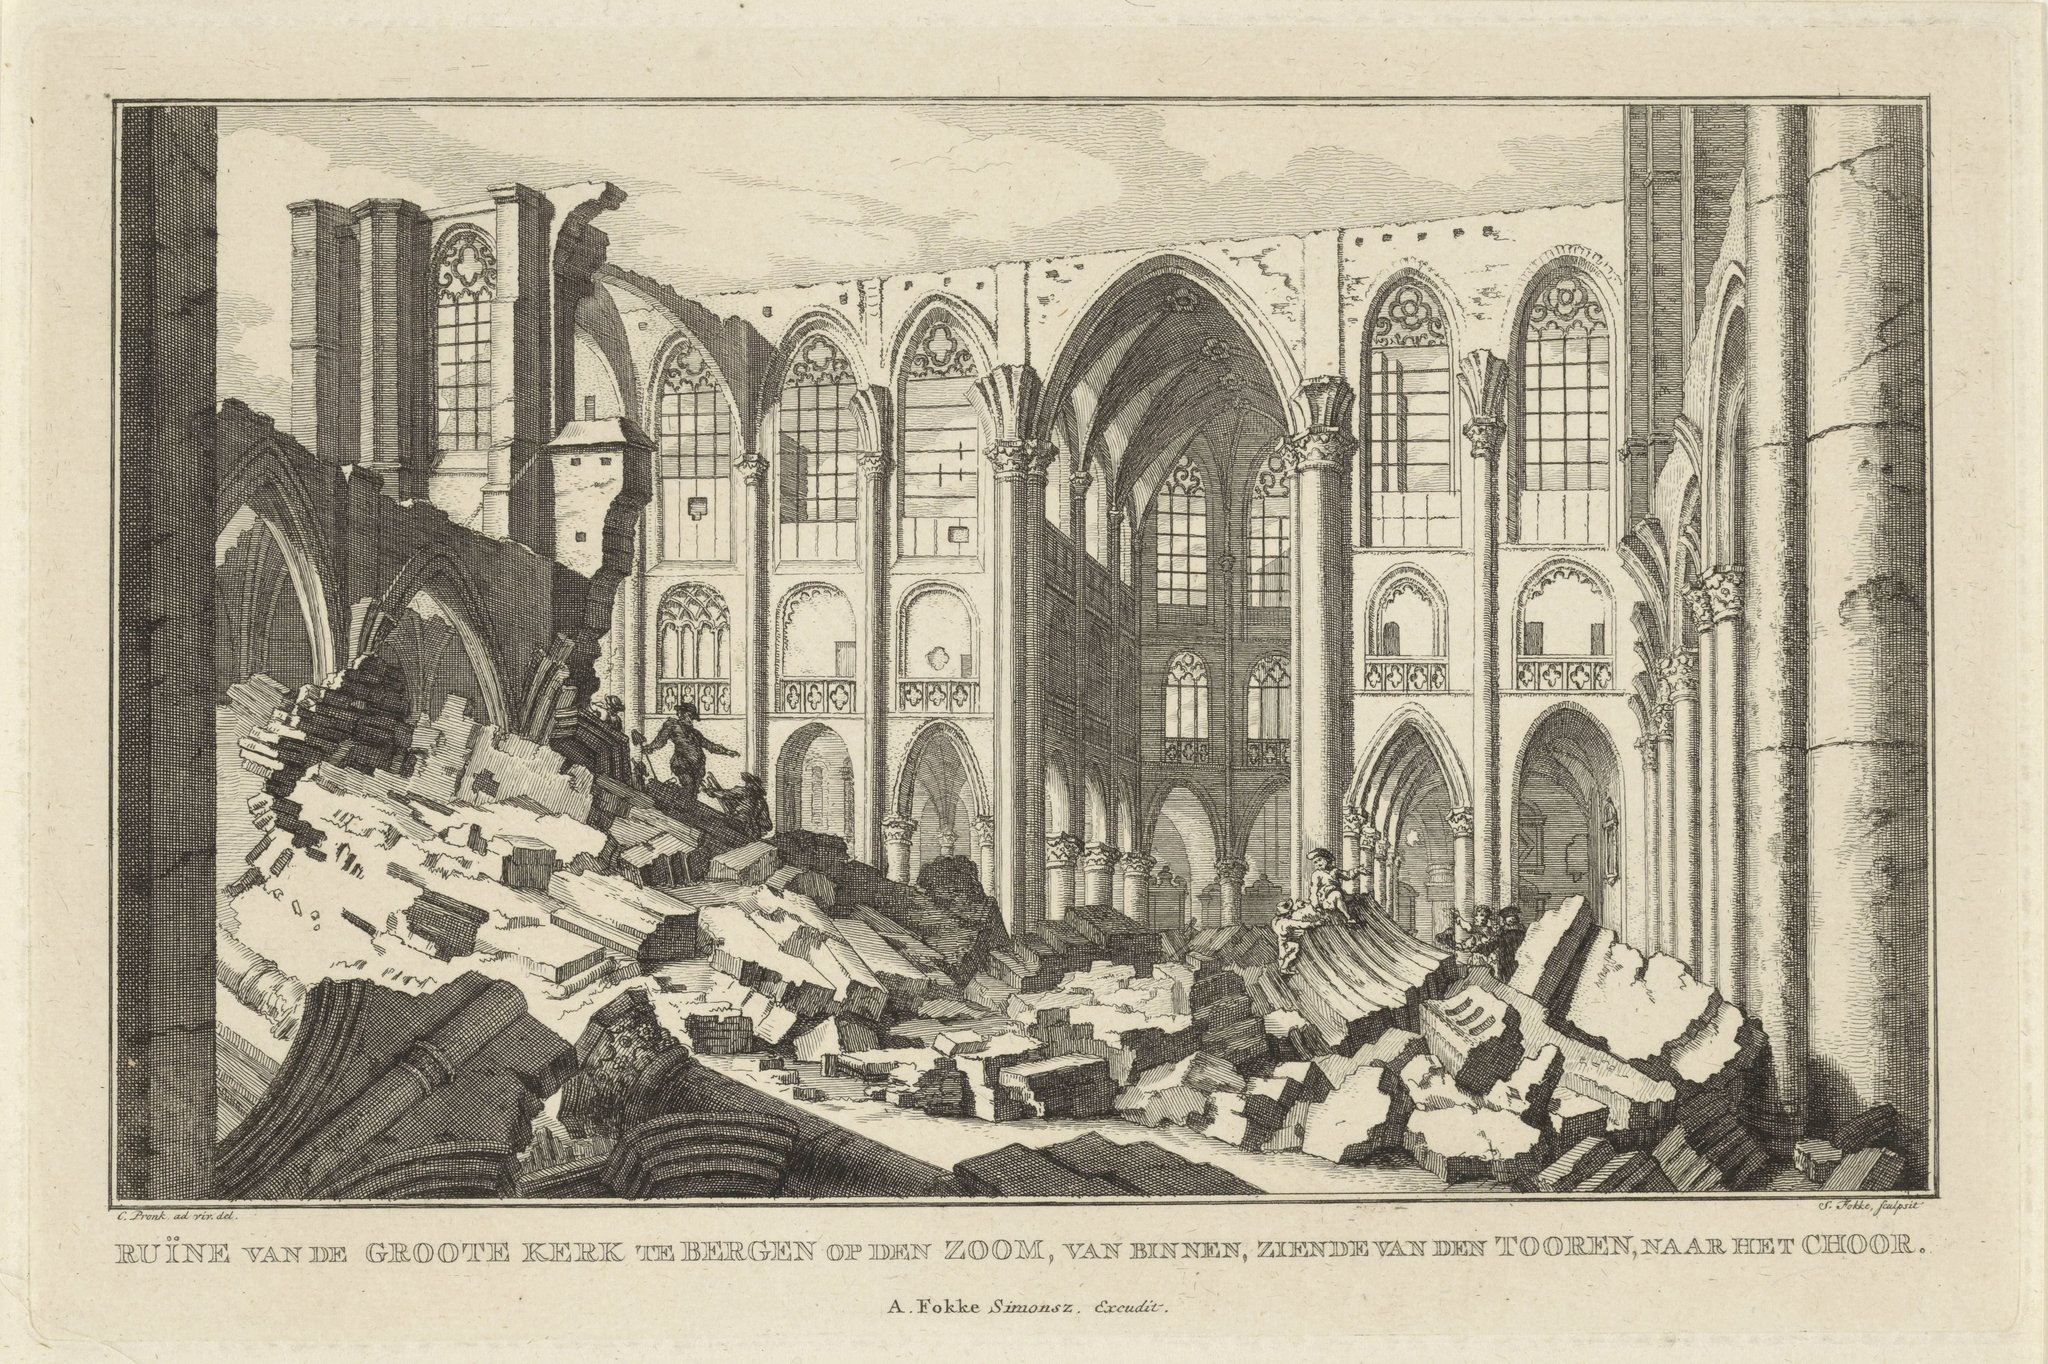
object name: book illustration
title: Tien gezichten van de ruïnes na het beleg en de verwoesting van Bergen op Zoom in 1747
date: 1772-1780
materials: paper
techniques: etching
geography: amsterdam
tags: ruin of church, monastery, etc., devastated, ruined place or city (~ warfare), bergen op zoom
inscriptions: collector's mark: Lugt 2233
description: Prent ook gebruikt in: Beschryving der stad Bergen op den Zoom (…). 1e druk. Amsterdam: Arend Fokke Simonsz., 1780. Muller geeft aan dat de prenten door Simon Fokke in 1772 naar de tekeningen van Pronk uit 1748 zijn vervaardigd. In de Collecties Thuis in Brabant (collecties in Brabantse musea en archieven) is een ontwerptekening (met inv.nr.: BC-Tha oai:tha.uvt.nl:709121) voor deze prent in de serie bewaard met de annotatie: Hoogstraat. na t Leven geschest (sic) door C.Pronk 1748. opgetekent door S. Fokke 1772.